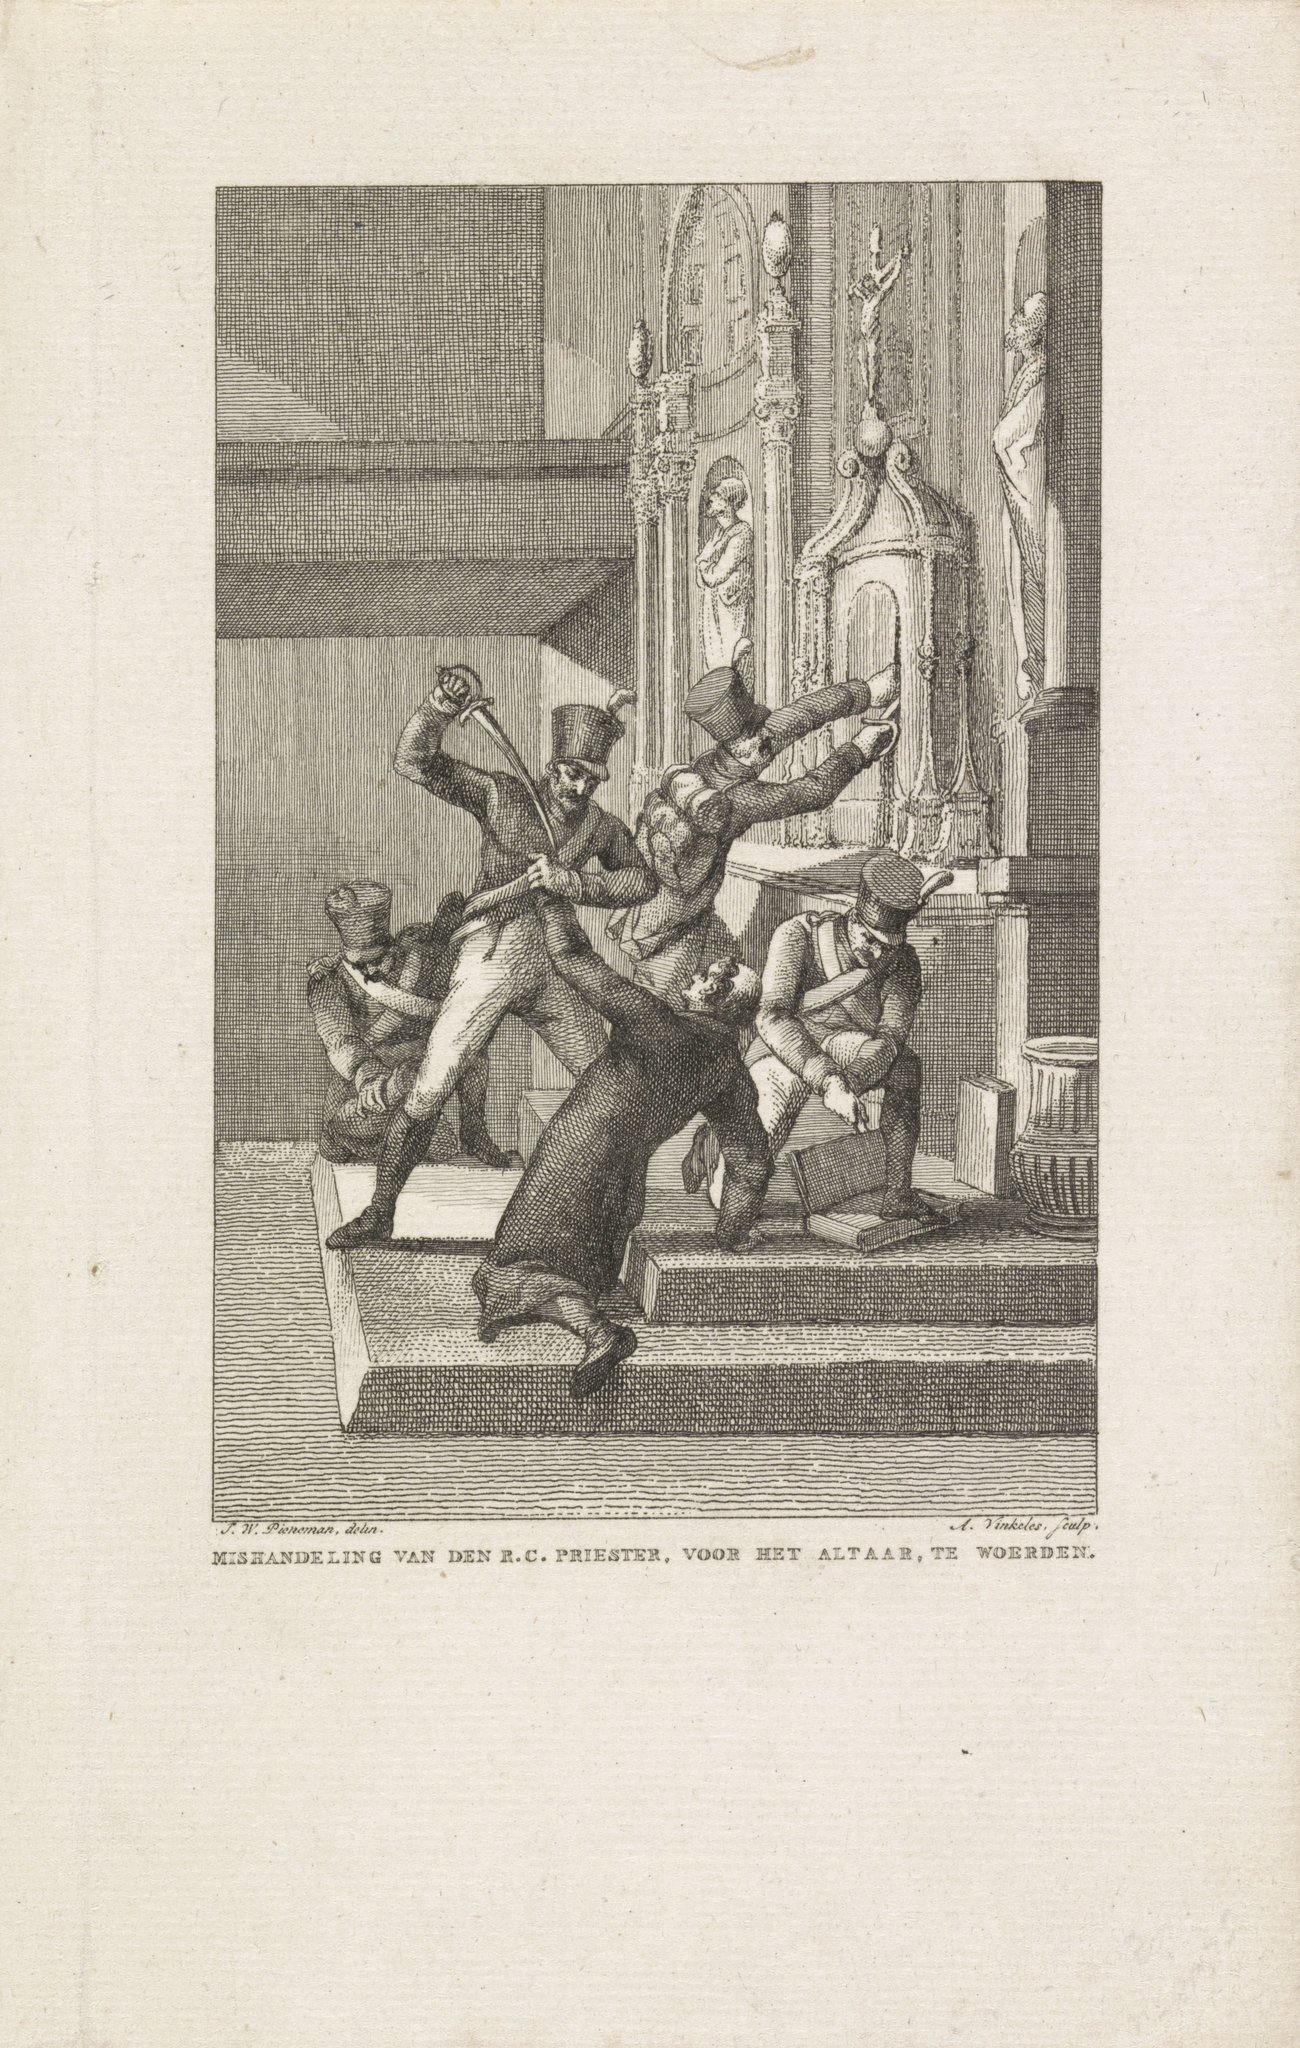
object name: print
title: Plundering van de katholieke kerk te Woerden, 1813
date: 1814-1816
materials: paper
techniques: engraving, etching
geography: netherlands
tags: plundering ~ soldiers, plundering of churchbuilding, convent, etc.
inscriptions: collector's mark: Lugt 2228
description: Gebruikt als illustratie in: J. Konijnenburg, Nationaal gedenkboek der hernieuwde Nederlandsche Unie, van den jare 1813, 's-Gravenhage: Johannes Allart, 1816. Herhaling van de prent gebruikt in: Jan Meulman, Woerden in slagtmaand MDCCCXIII, 's-Gravenhage: Johannes Allart, 1814. Zie FMH 5854/6.